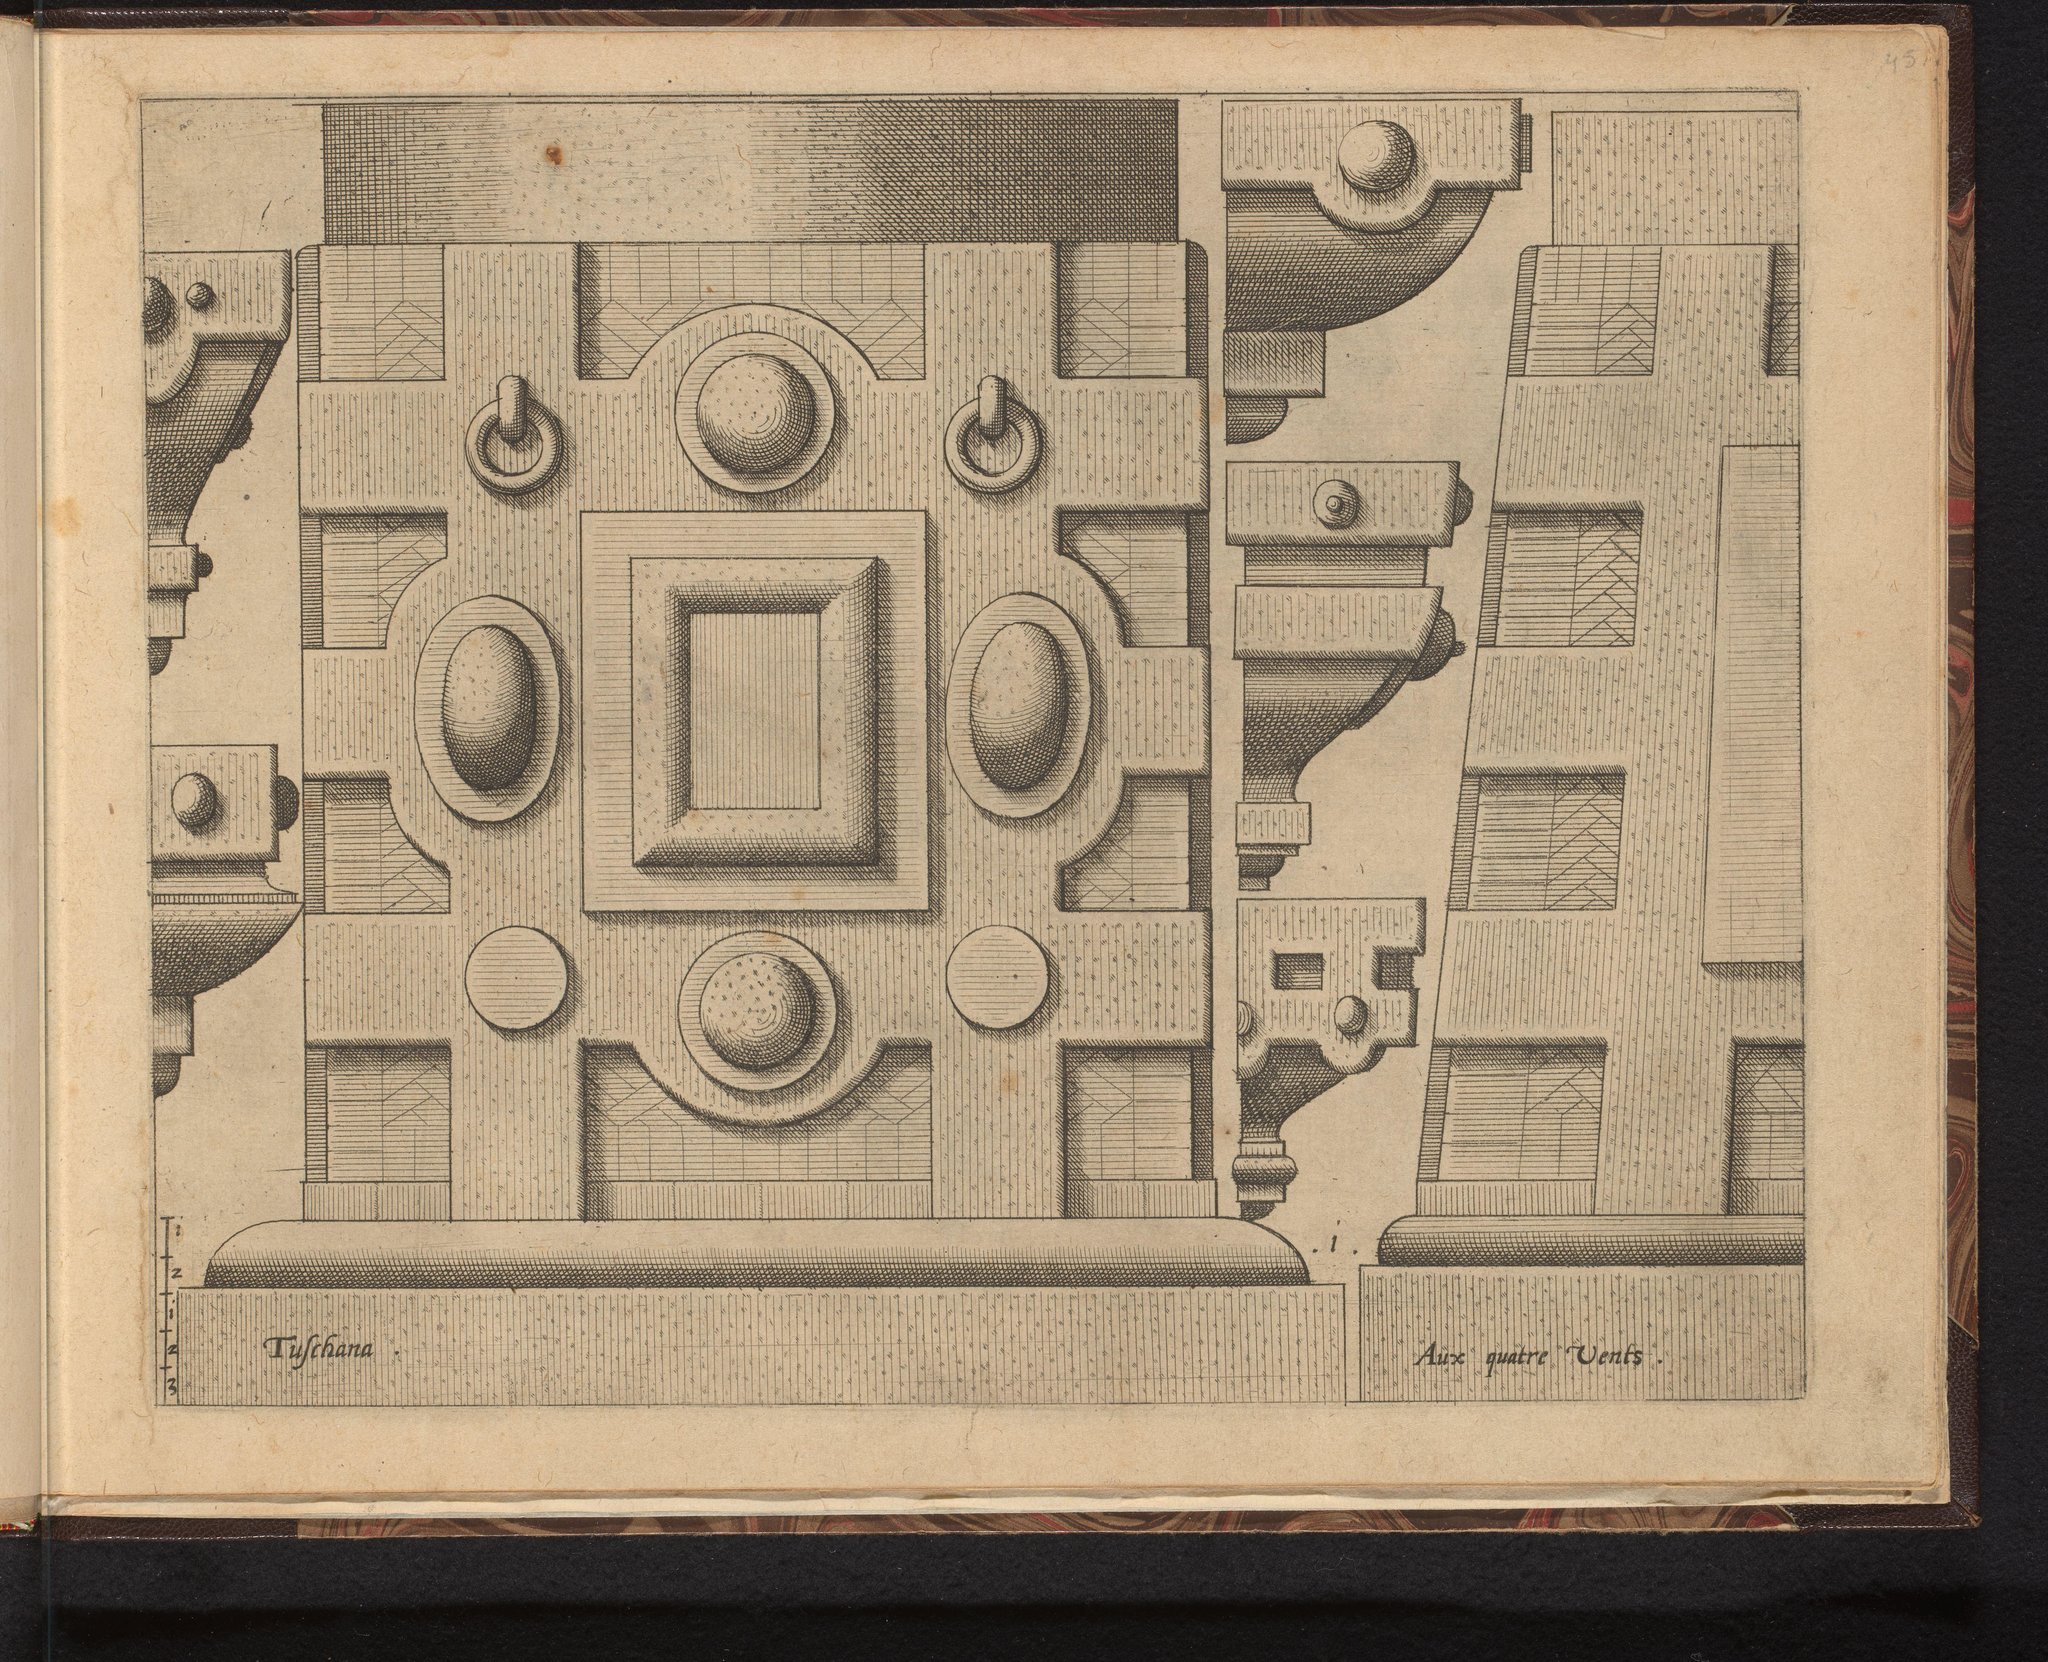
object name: print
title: Hele en halve piëdestal en vijf consoles, in de Toscaanse Orde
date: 1578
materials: paper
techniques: etching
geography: antwerp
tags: tuscan order ~ architecture, other architectural details (console), pedestal of a piece of sculpture (perhaps in the form of a herm)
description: Een hele en halve piëdestal en vijf consoles met rustica. Daarbij vijf consoles. Op de voorstelling is linksonder een schaalverdeling aangegeven. De prent maakt deel uit van een album.